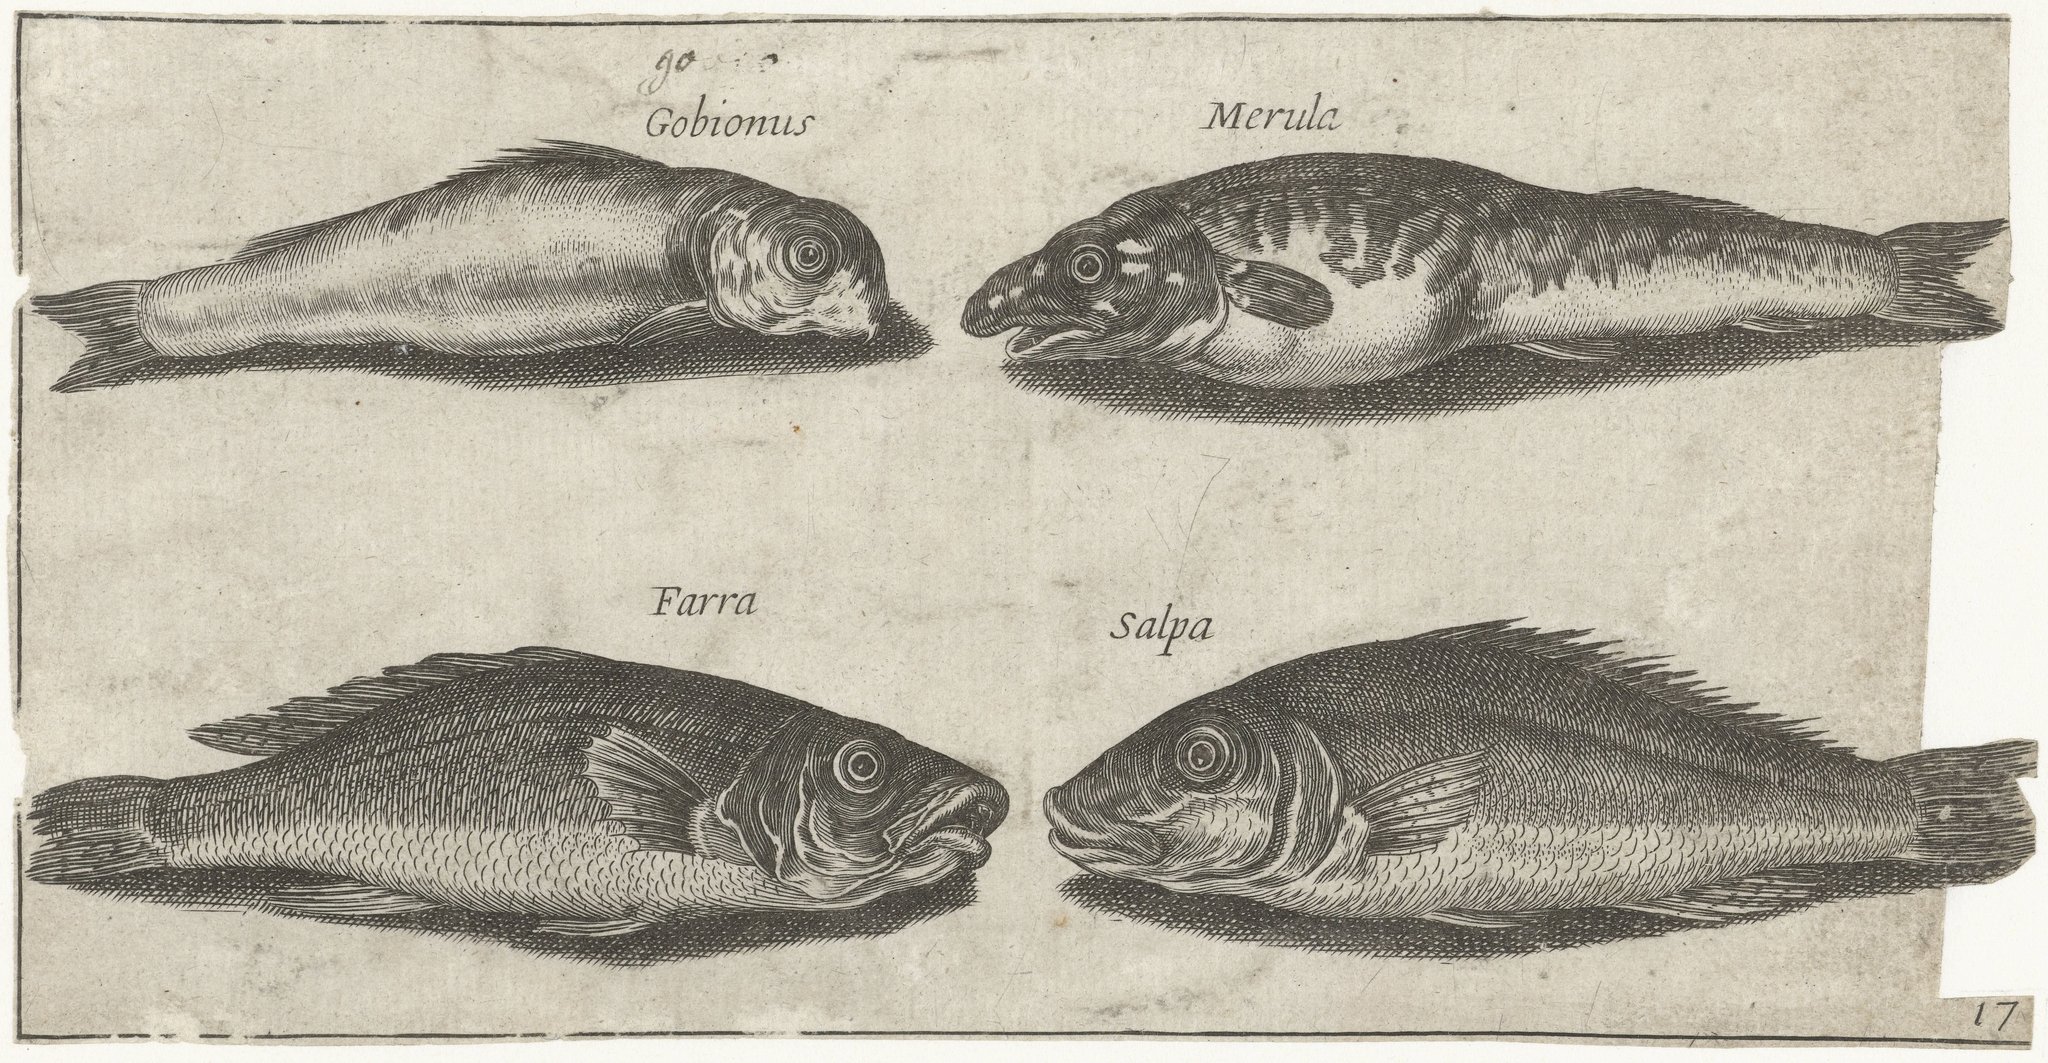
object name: print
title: Piscivm vivae icones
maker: pierre firens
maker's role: print maker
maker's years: 1580-1638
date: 1600-1638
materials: paper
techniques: engraving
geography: paris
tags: fishes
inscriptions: collector's mark: Lugt 2228